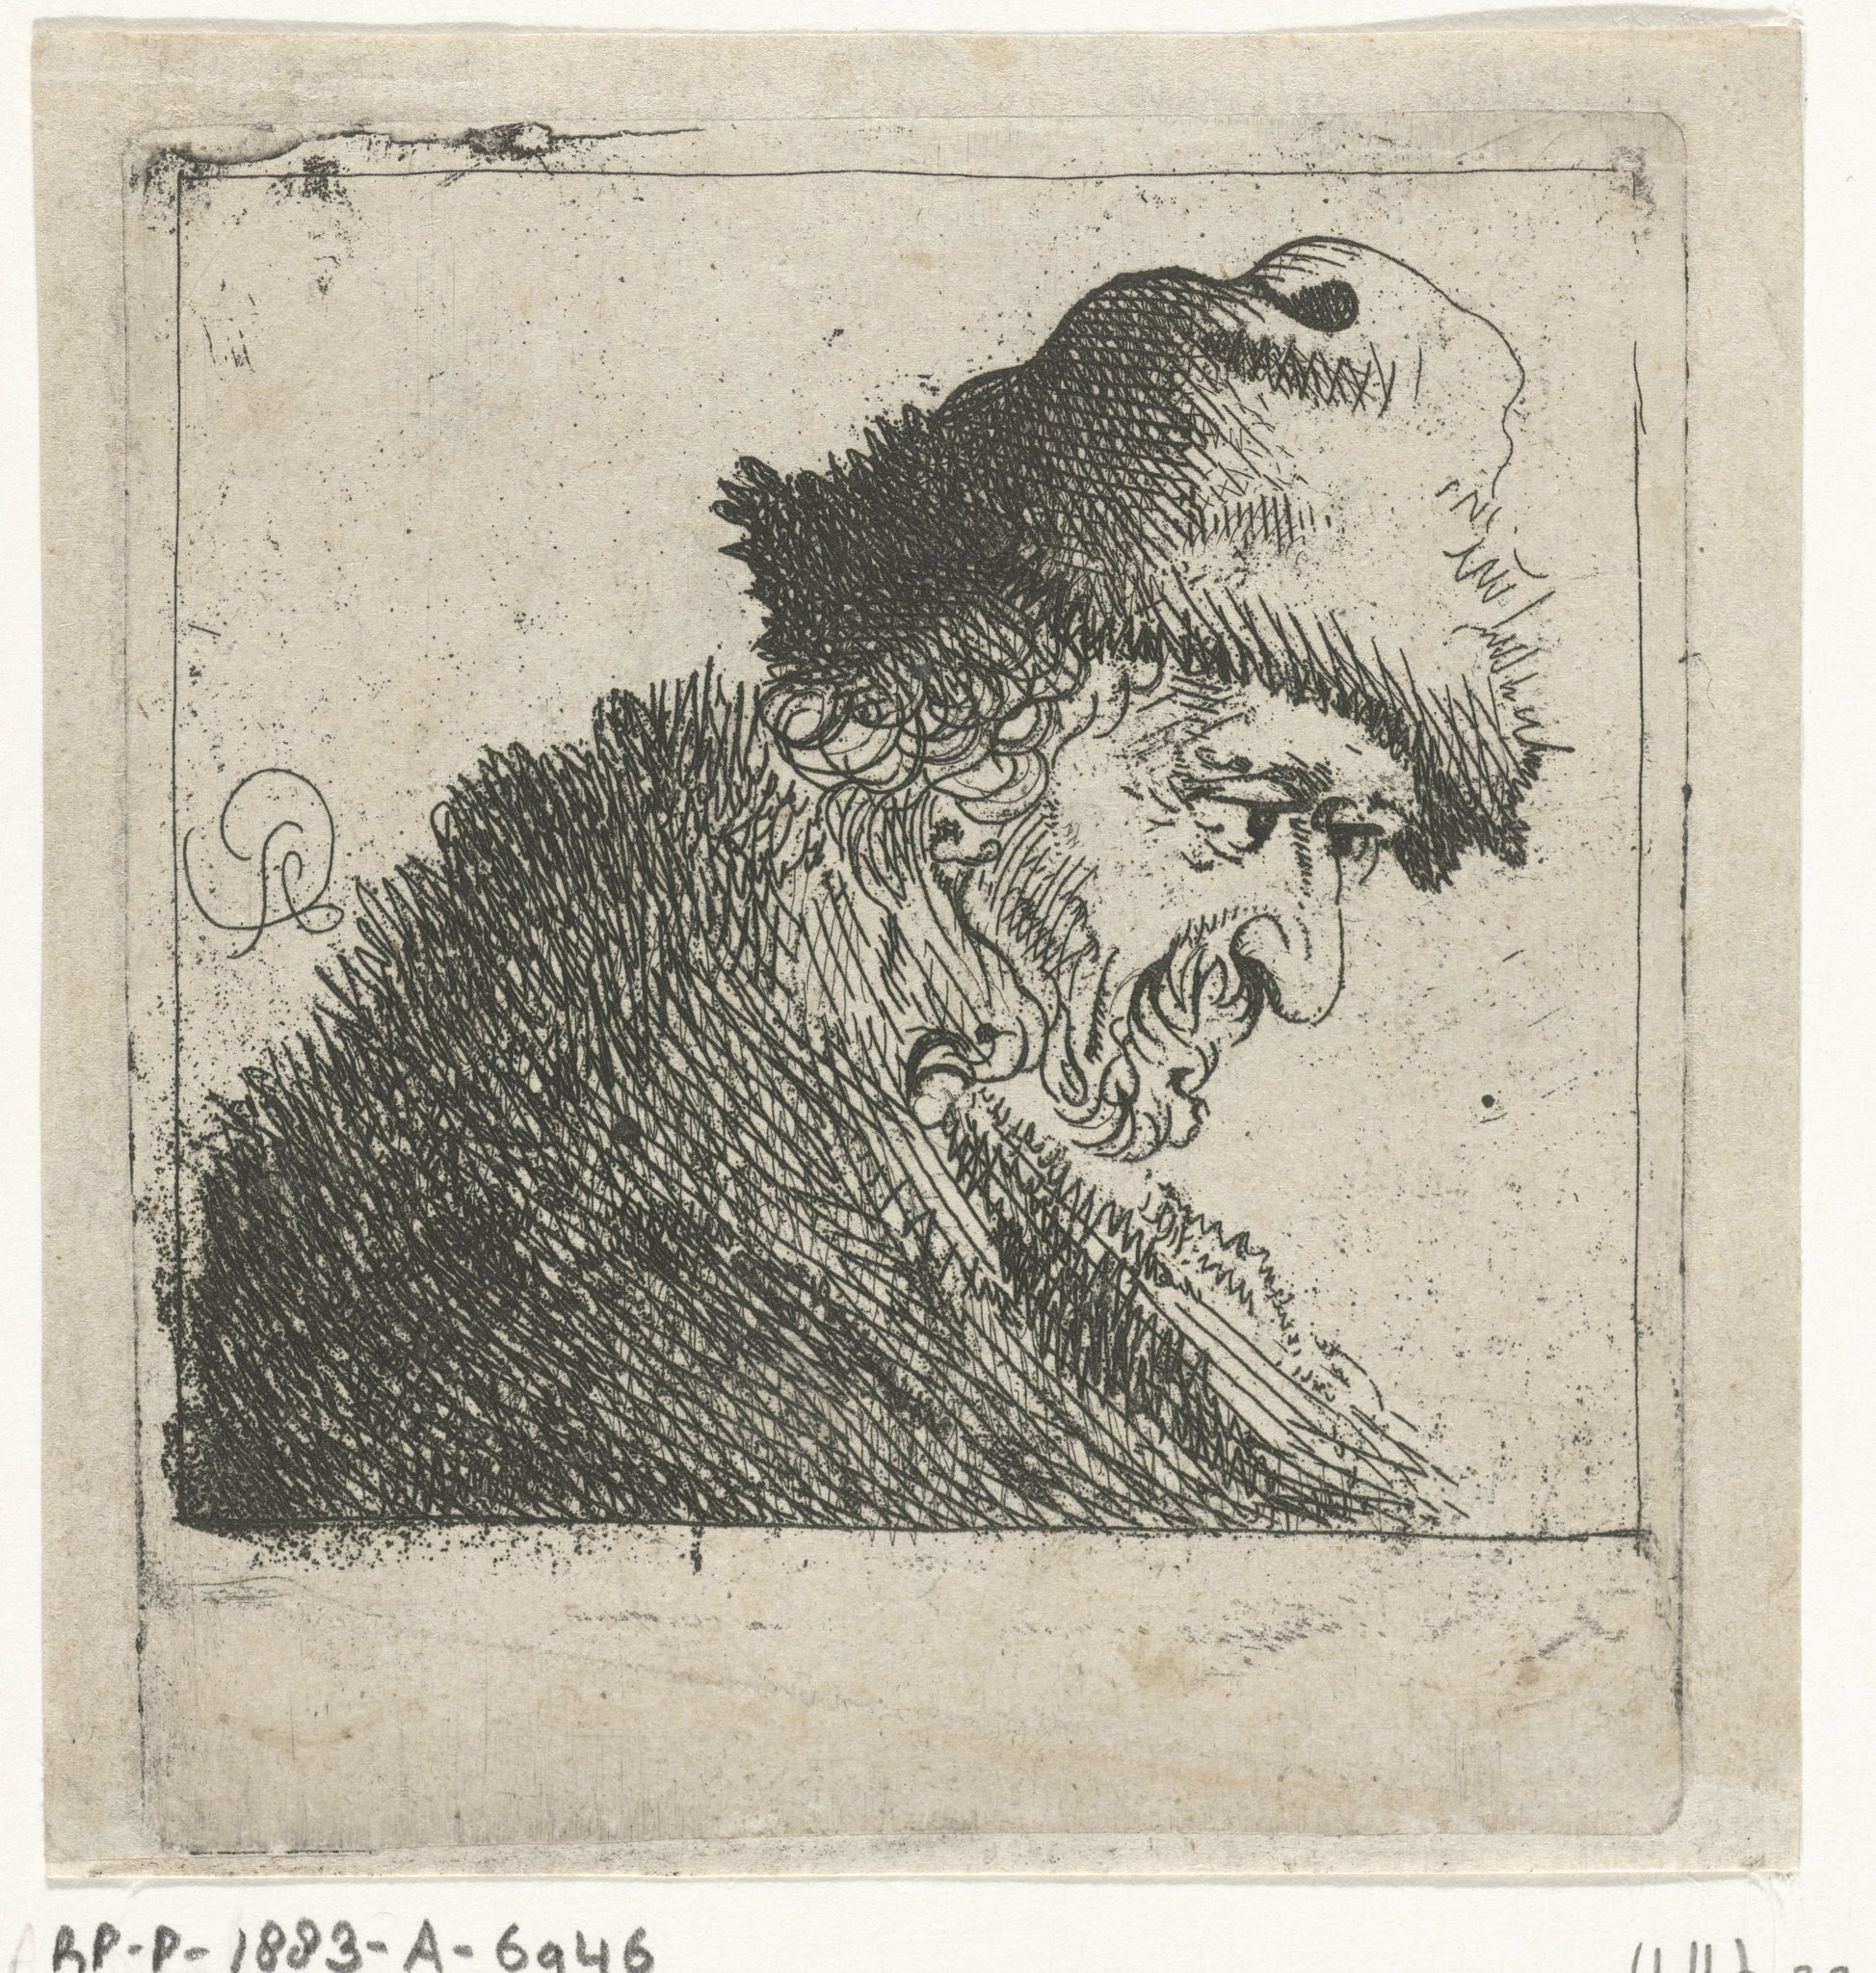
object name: print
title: Portret van een oude man met een bontmuts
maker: pieter jansz quast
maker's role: draughtsman, painter, print maker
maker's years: 1605-1647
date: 1615-1647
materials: paper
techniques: etching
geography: netherlands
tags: head-gear: cap (+ men's clothes), old man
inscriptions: collector's mark: Lugt 2227